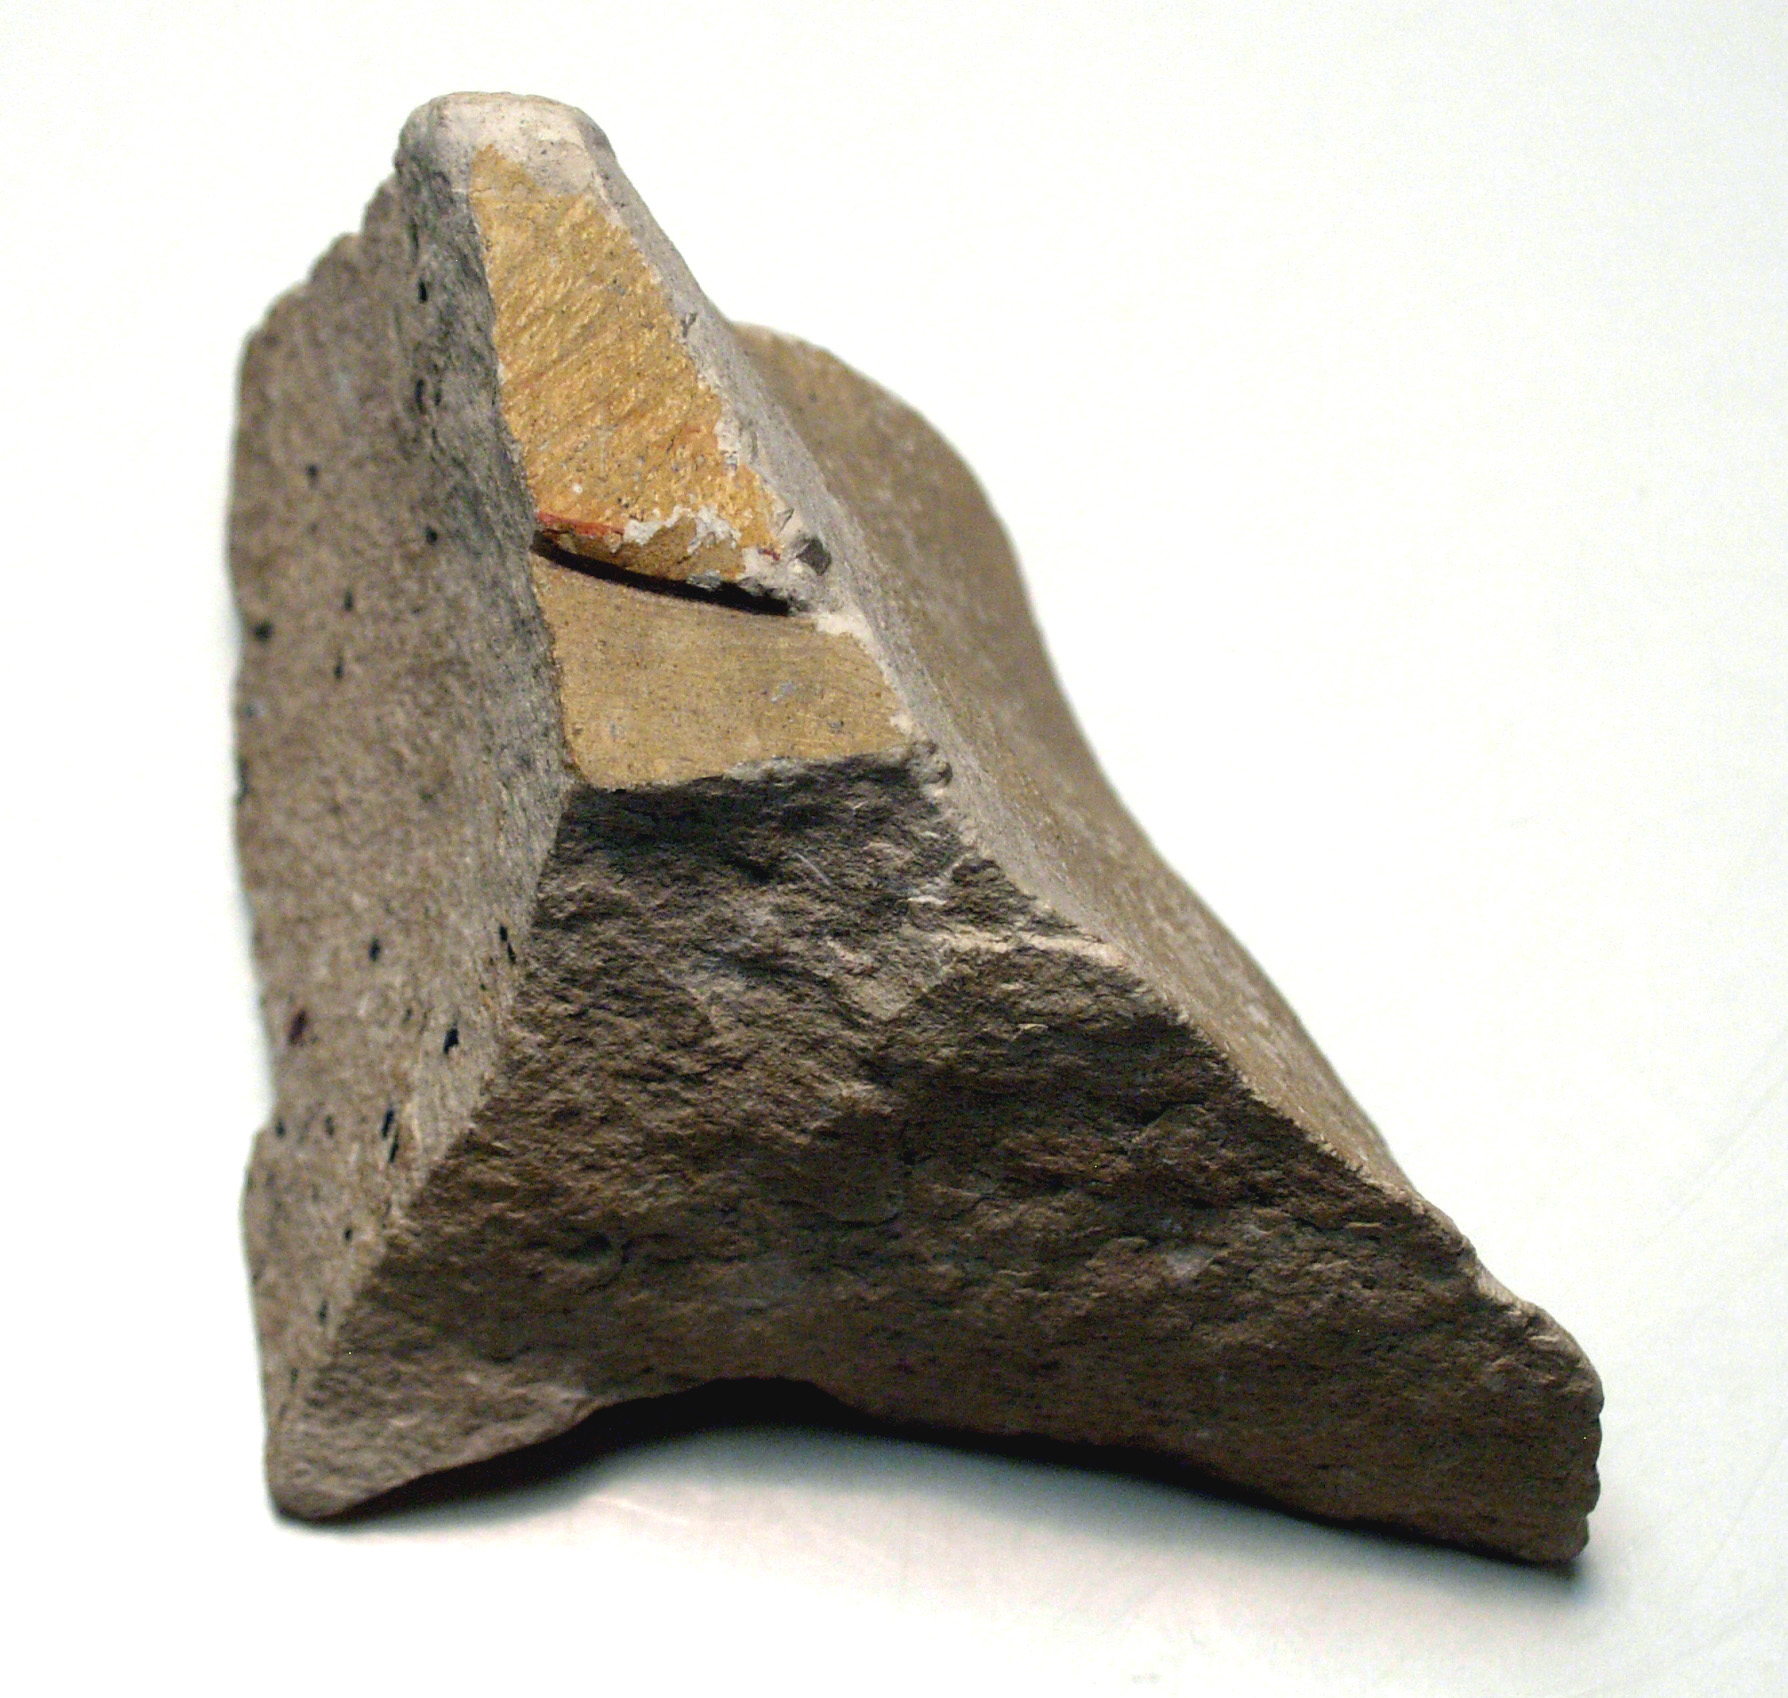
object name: relief, tomb of nespekashuty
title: Raised relief fragment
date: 664-610 BCE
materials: limestone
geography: egypt